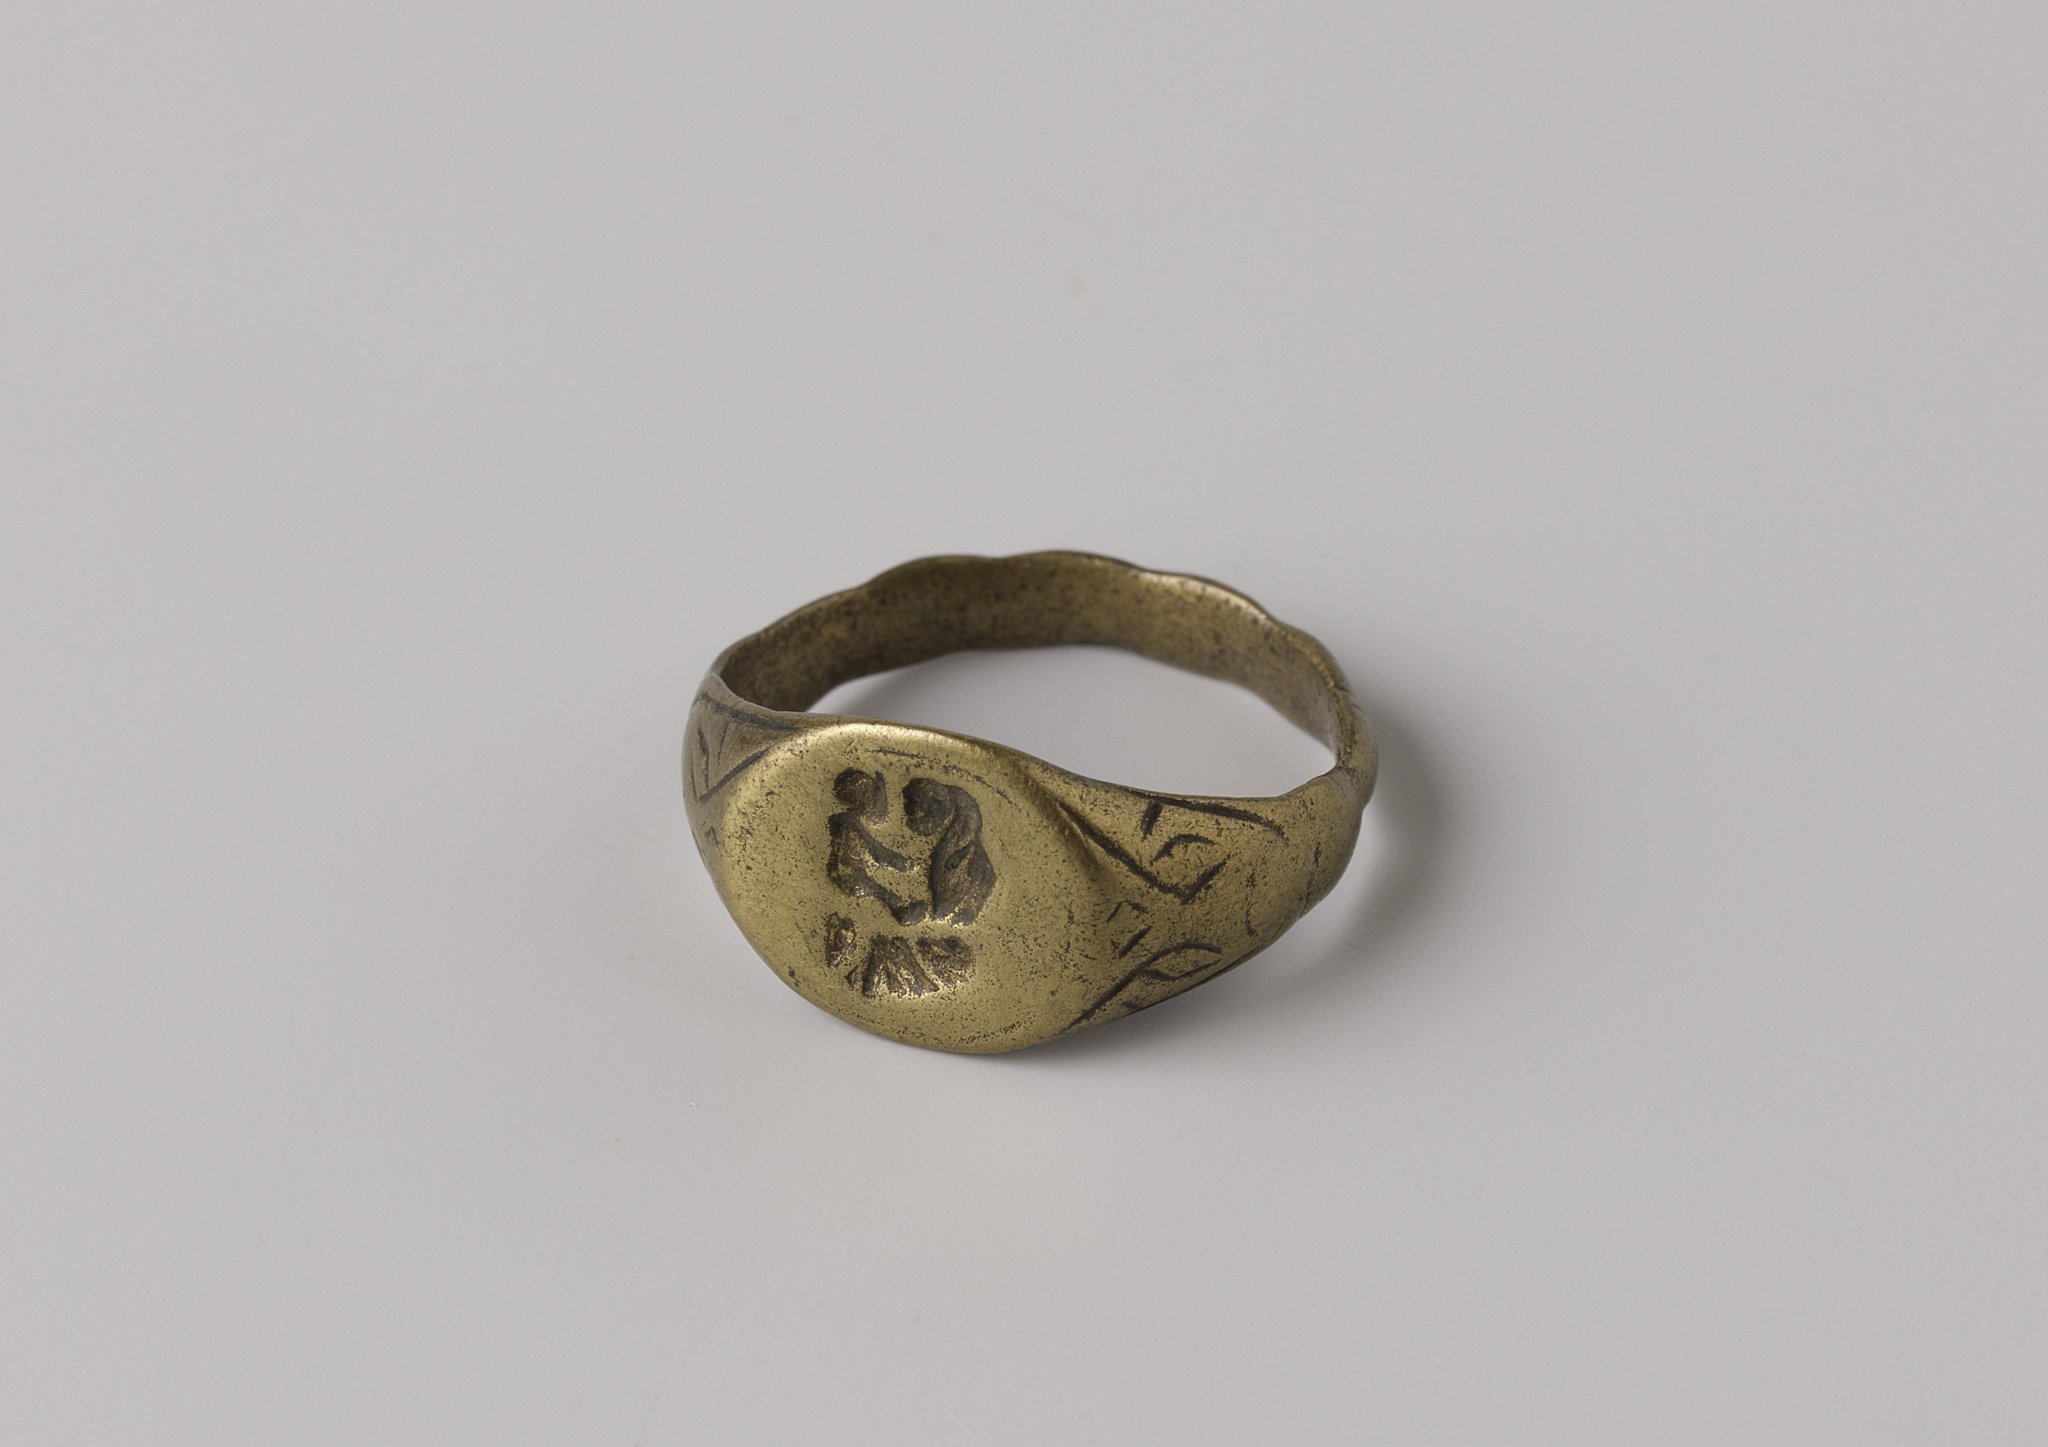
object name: ring, signet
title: Zegelring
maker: Anonymous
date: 1000-1900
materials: copper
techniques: engraving, forging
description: Koperen ring met ovalen stempel waarop en creux een zittende vrouw met kind op haar schoot, zeer vaag. De ring zelf heeft de vorm van een touw maar sterk afgeplat, aan weerszijden van de stempel zijn abstrakte motieven gegraveerd. Letters AVI?